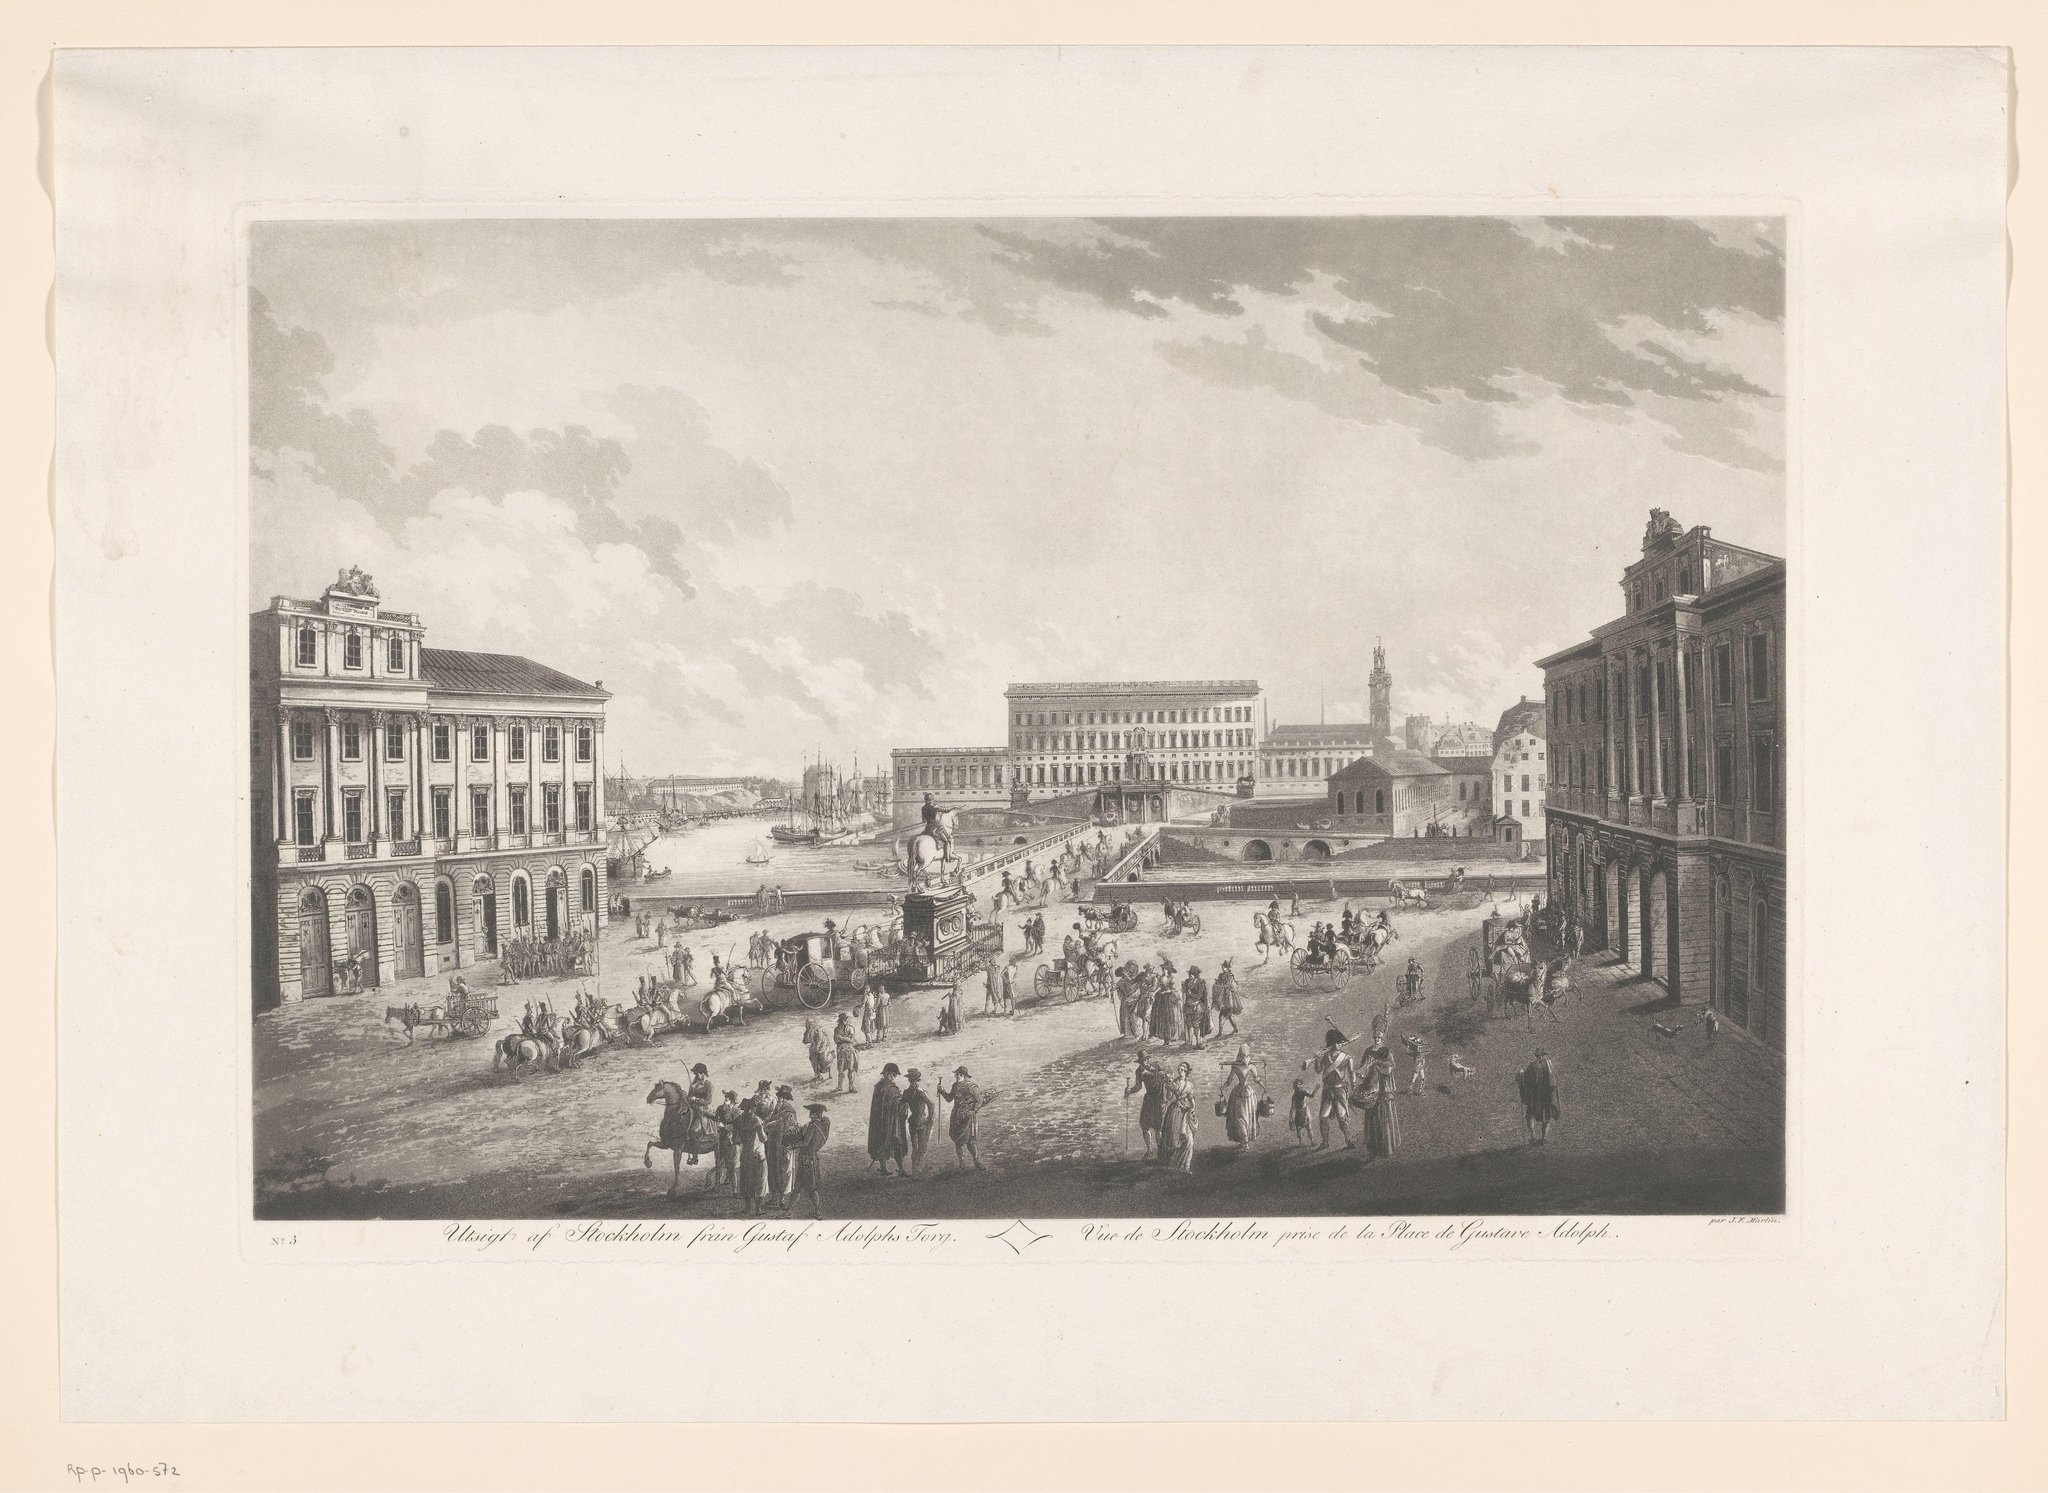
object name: print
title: Vue de Stockholm prise de la Place de Gustave Adolphe / Utsigt af Stockholm fran Gustaf Adolphs Torg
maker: johan fredrik martin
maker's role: print maker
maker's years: 1755-1816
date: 1805-1818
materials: paper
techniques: aquatint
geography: stockholm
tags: monument, statue, square, place, circus, etc. (+ city(-scape) with figures, staffage), prospect of city, town panorama, silhouette of city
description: Gezicht op Stockholm vanaf Gustav Adolfs torg, een plein in het stadsdeel Norrmalm in het centrum van Stockholm. Linksonder genummerd: 3.